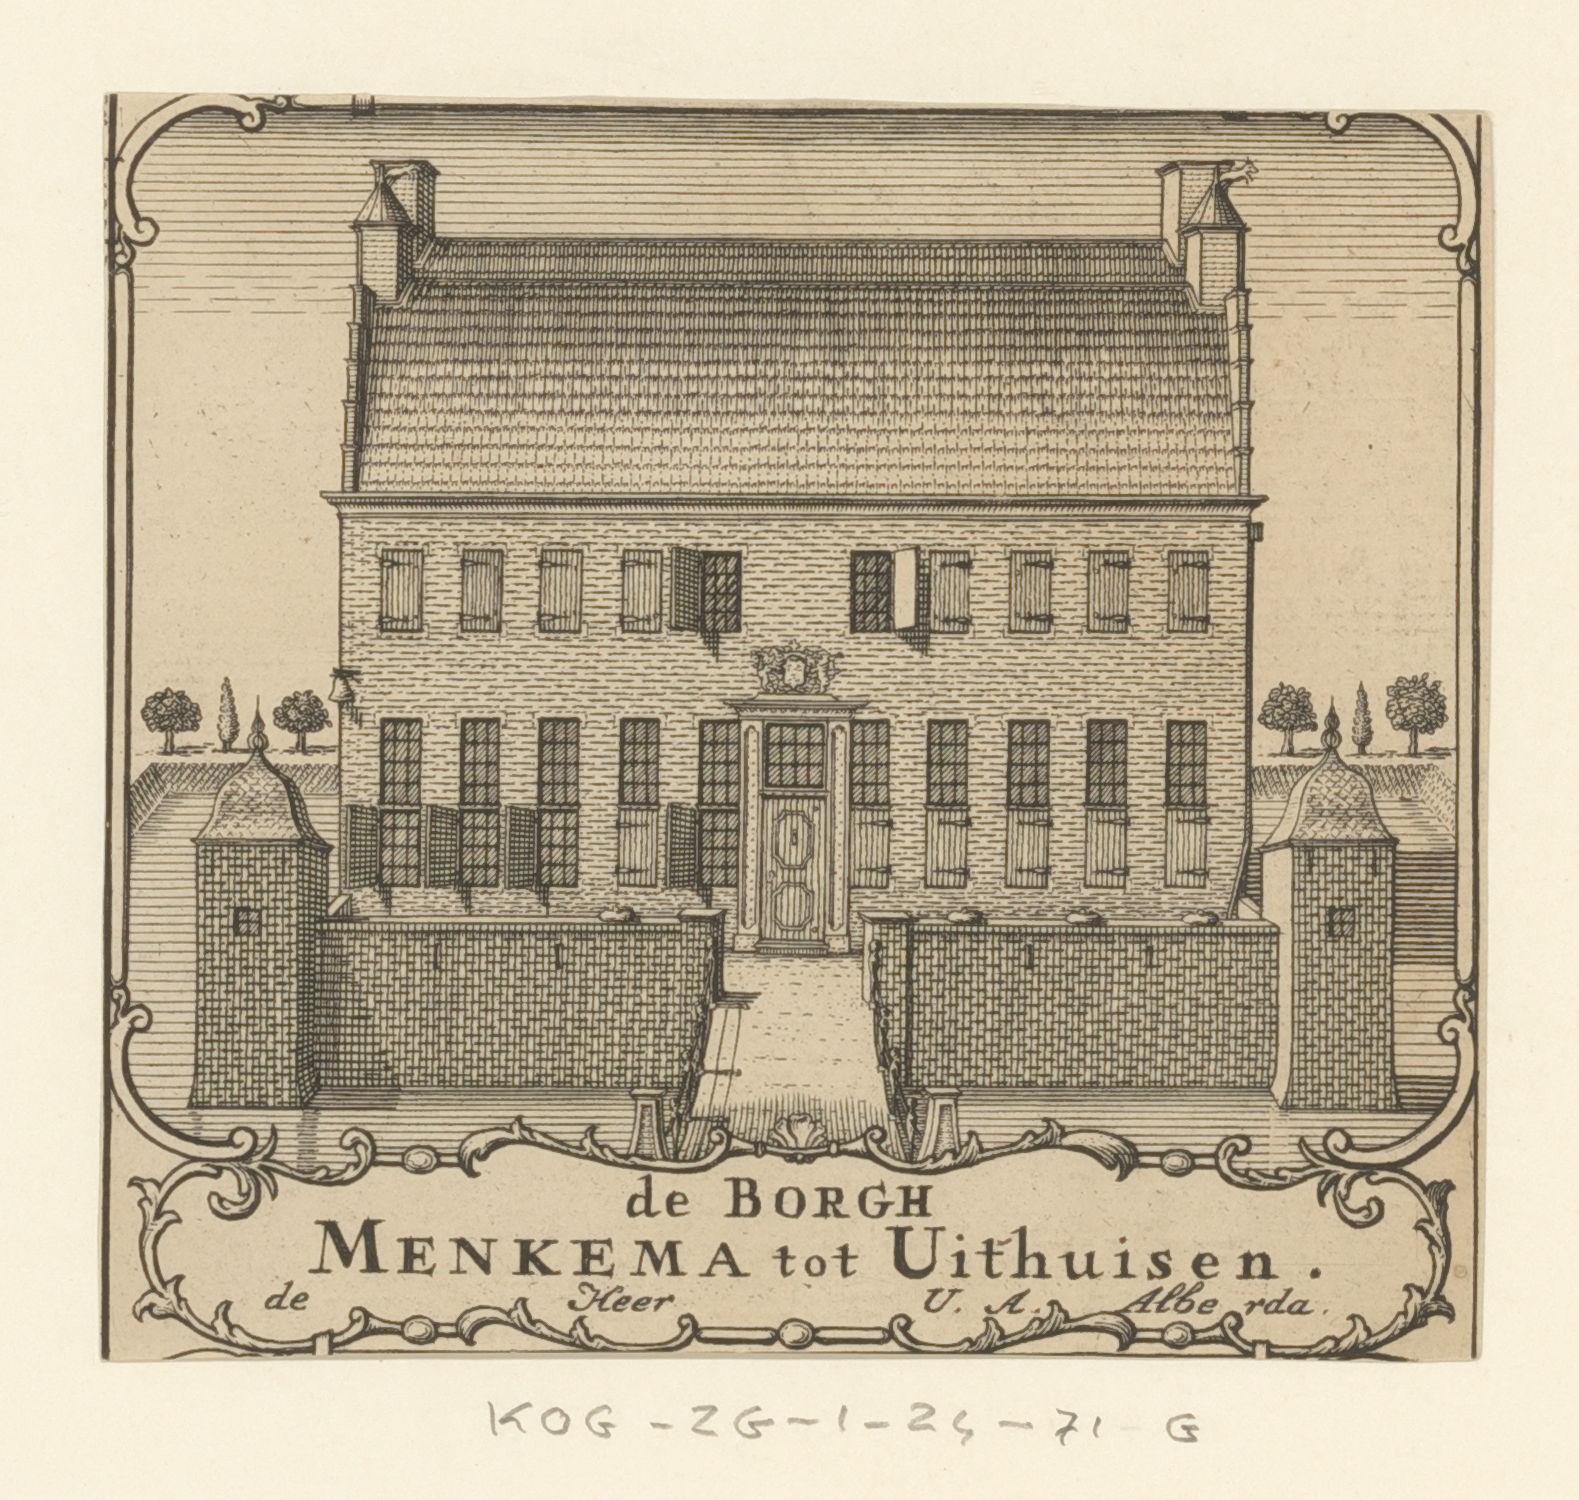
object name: print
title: De Borgh Lulema tot Warfhuisen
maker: theodorus beckeringh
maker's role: advocaat, cartograaf, rechter, regent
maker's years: 1712-1790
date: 1784-1849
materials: paper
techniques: engraving, etching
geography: groningen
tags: castle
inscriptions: collector's mark: Lugt 1641, stamp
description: Prent geknipt uit een grotere kaart met de titel: Nova Totius Provinciae Groningo-Omlandiae Tabula. Platen gesneden in 1777, voor het eerst uitgegeven 1784. Later ook uitgegeven in 1849.